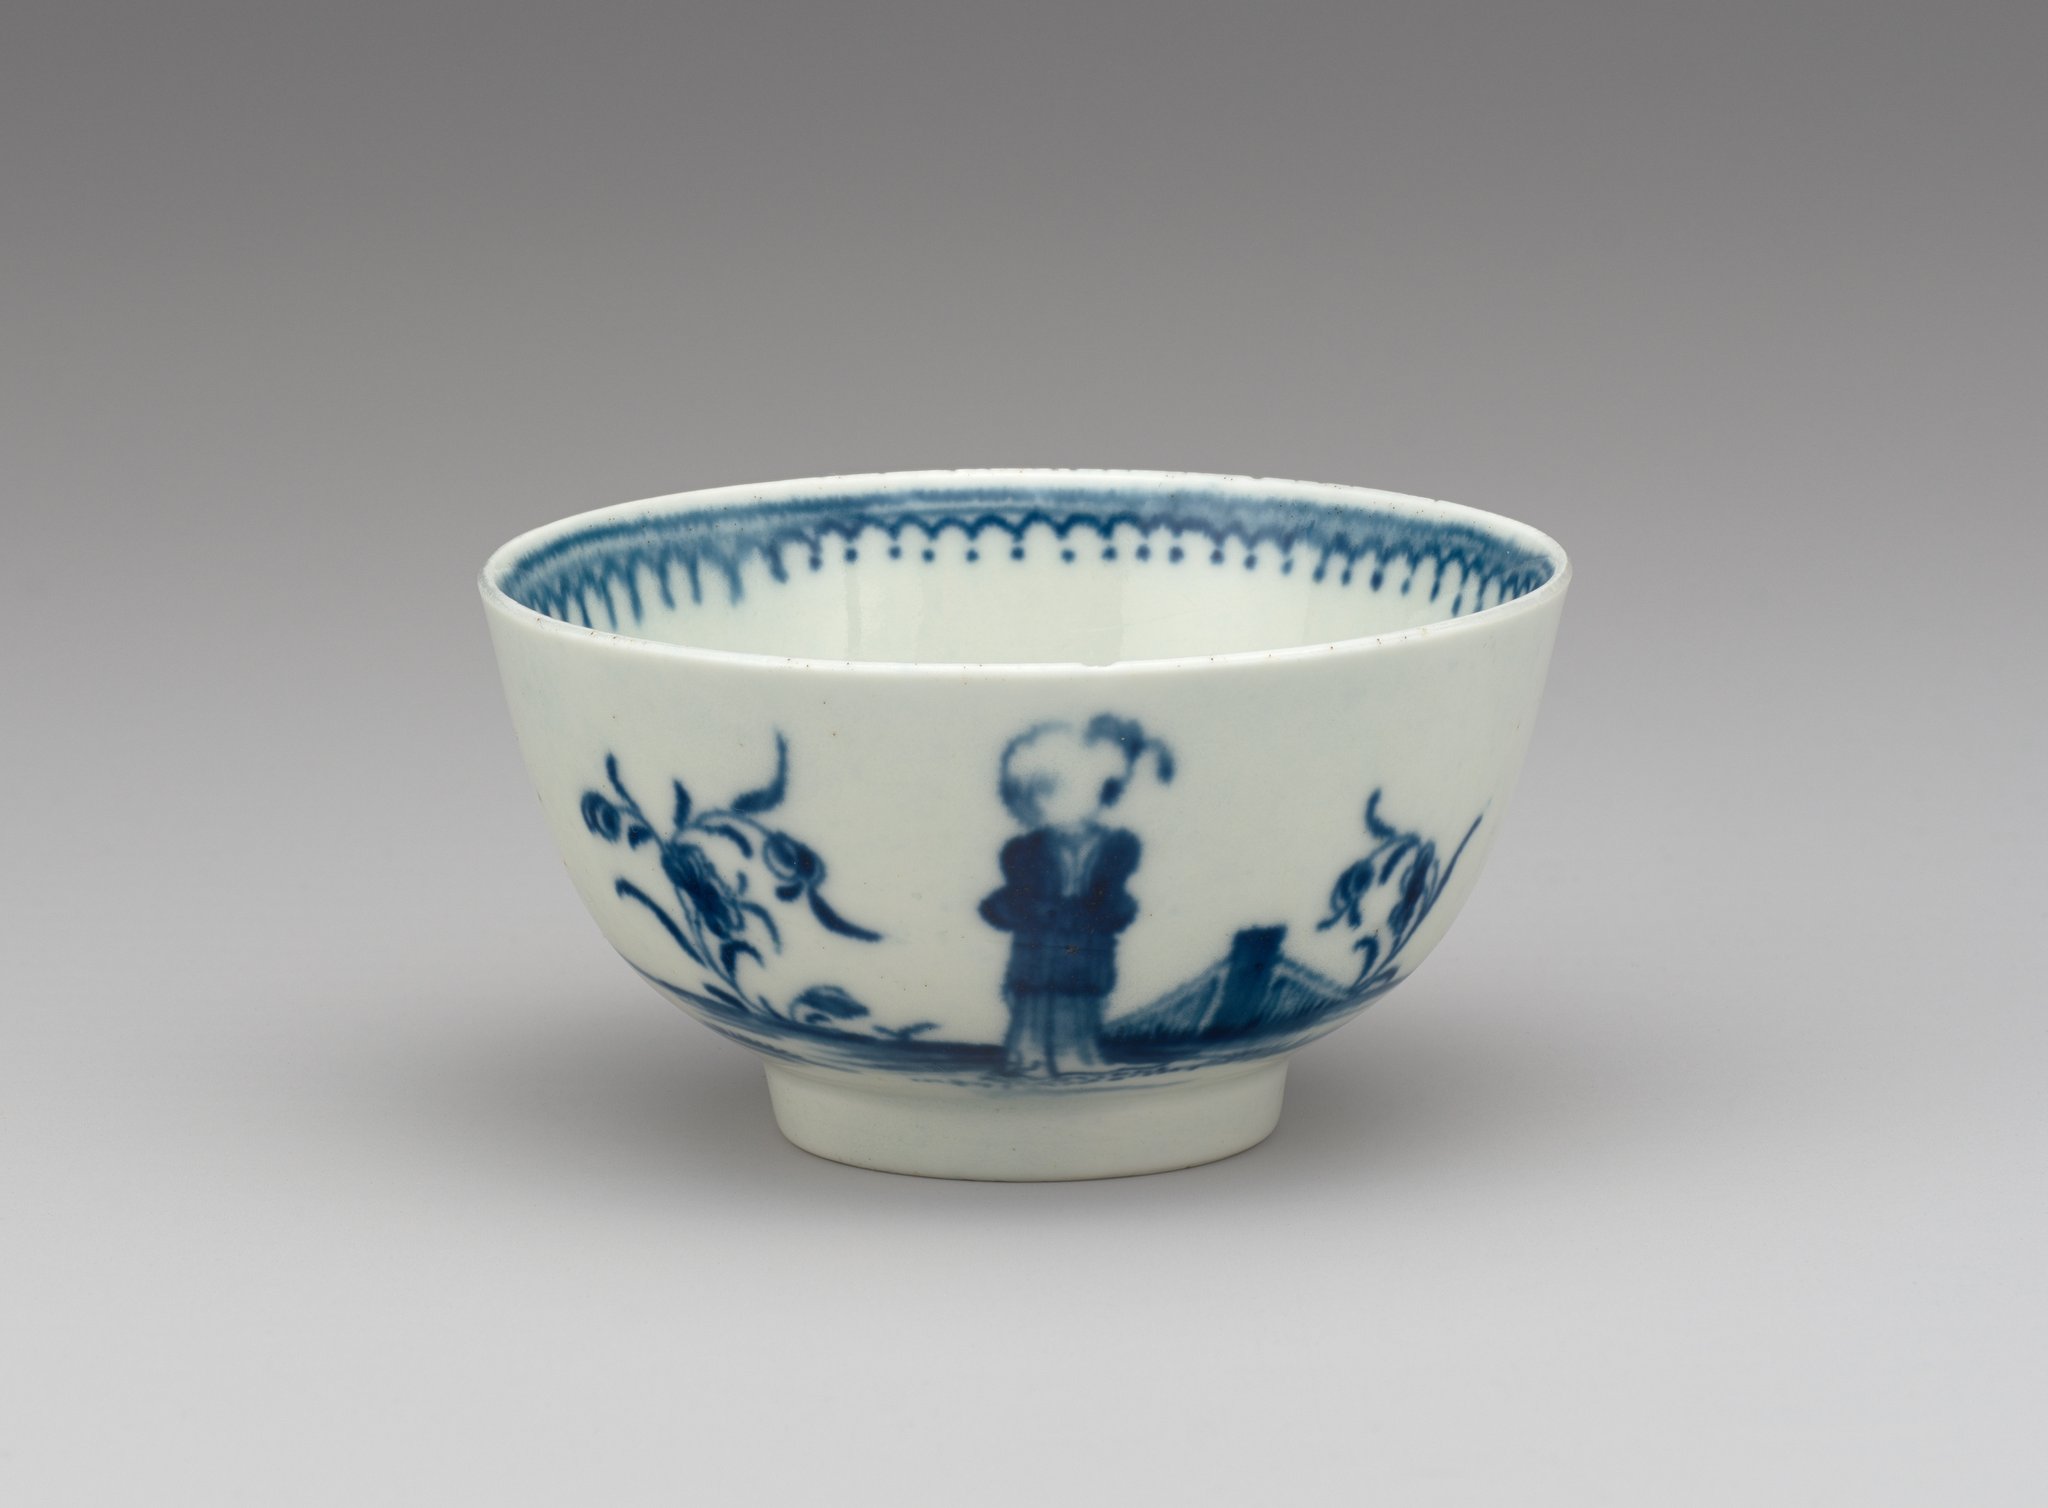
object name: teabowl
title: Two teabowls (part of a service)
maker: worcester factory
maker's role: factory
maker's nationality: british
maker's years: 1751-2008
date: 1760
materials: soft paste porcelain